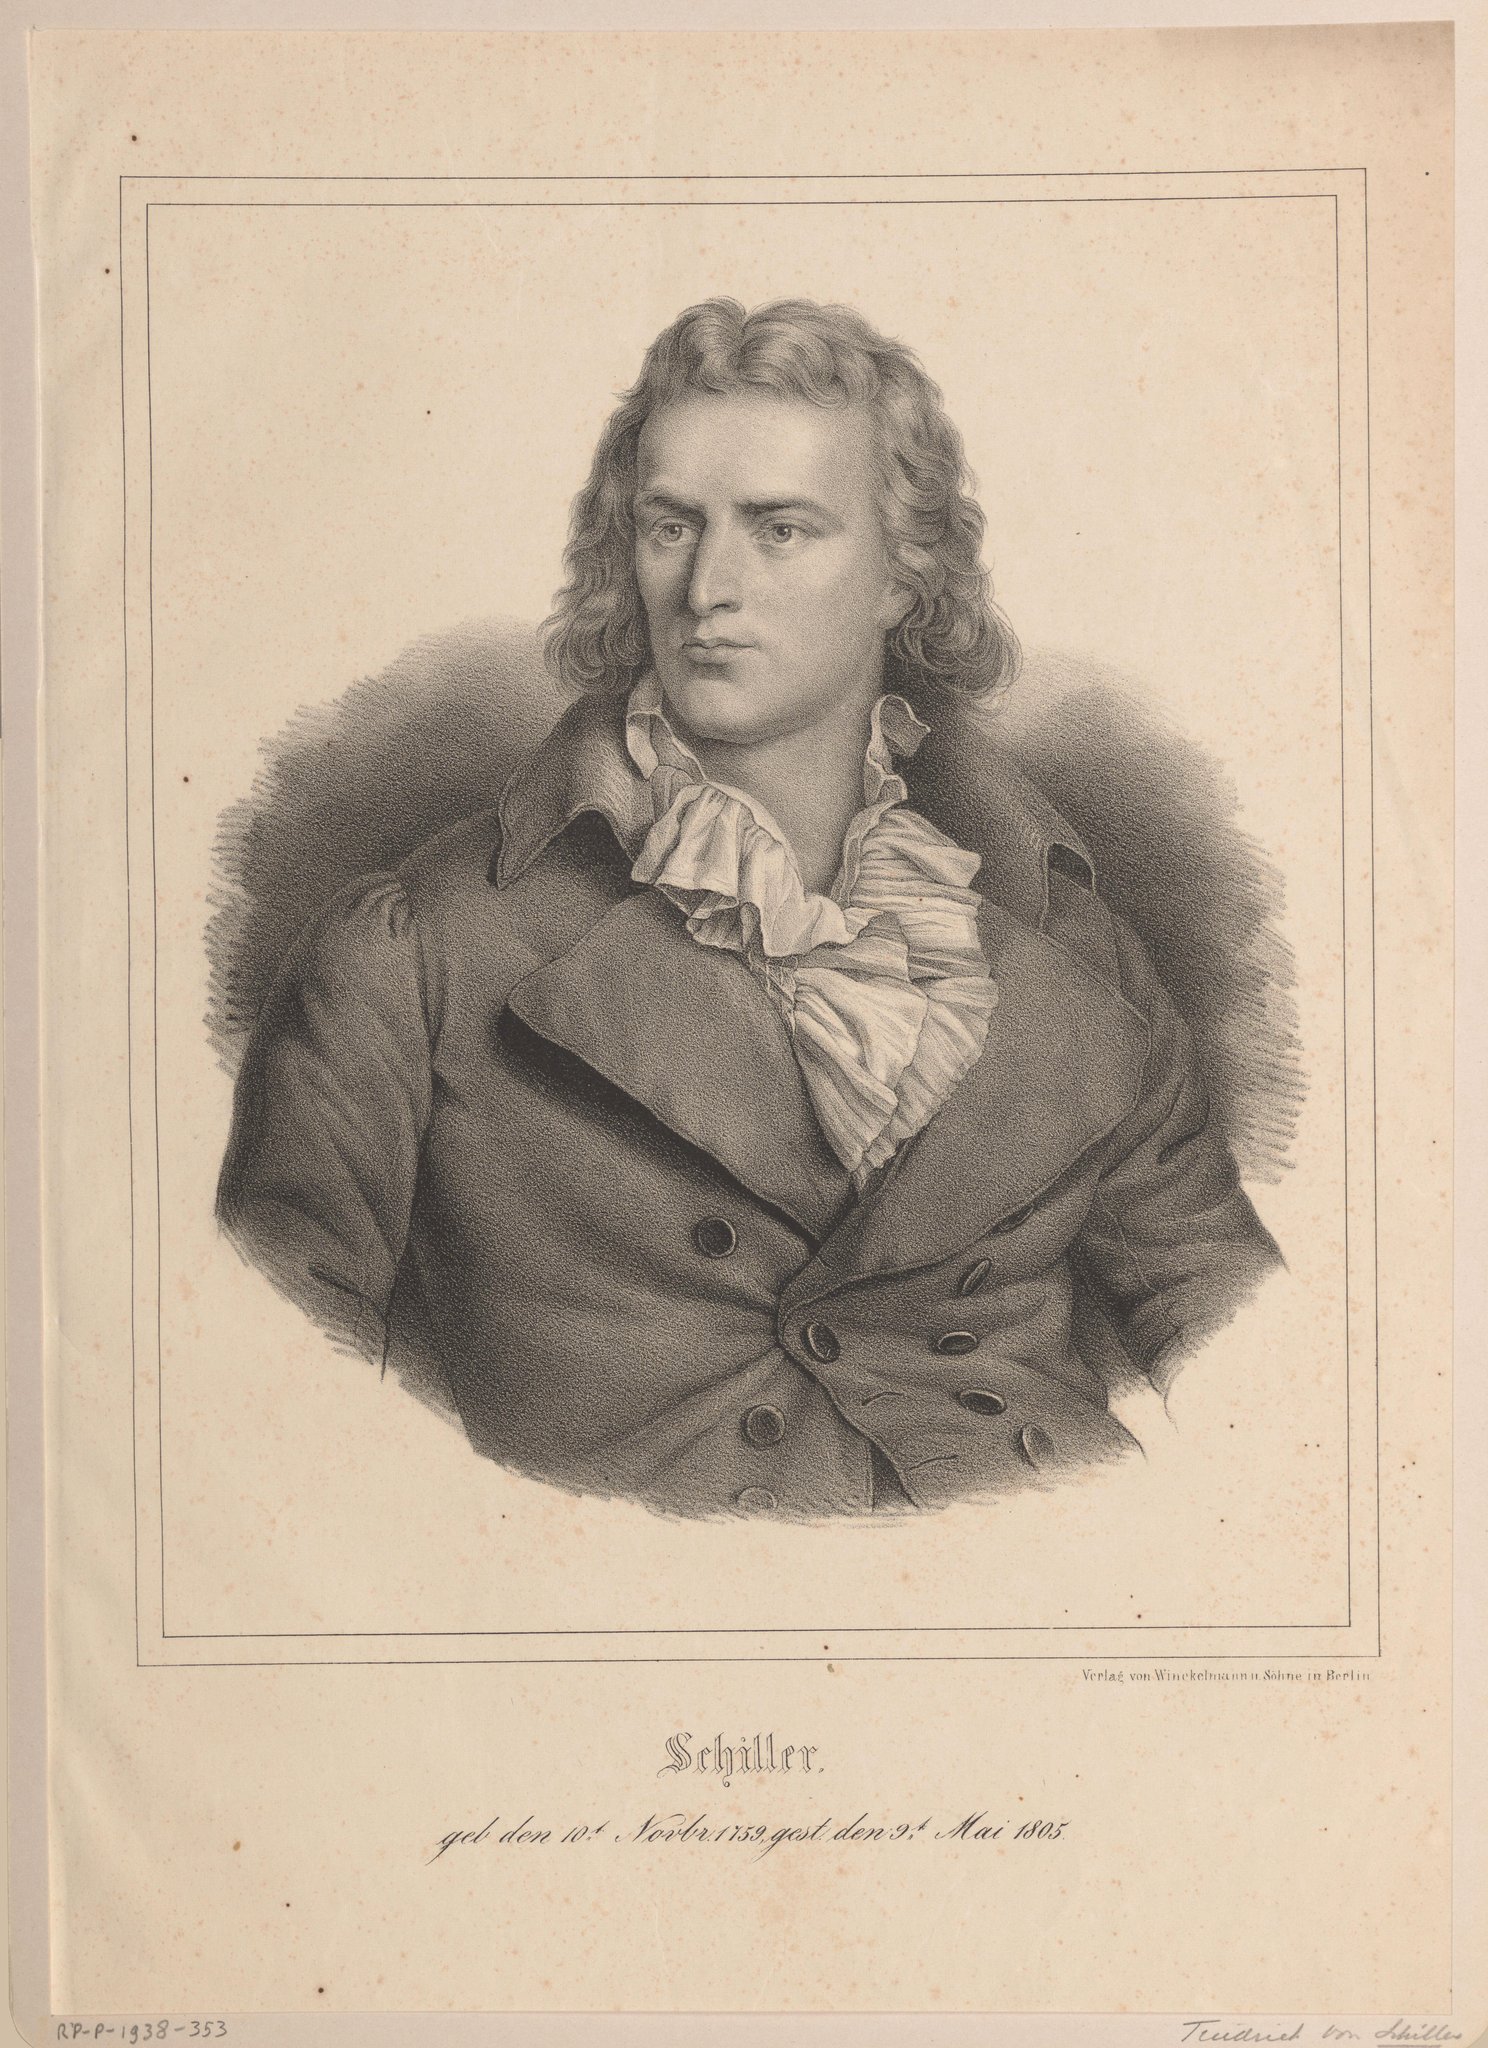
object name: print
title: Portret van Friedrich von Schiller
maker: Anonymous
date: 1830-1849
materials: paper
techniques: lithograph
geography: berlin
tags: friedrich von schiller, scholar, philosopher, historical persons, portrait of a writer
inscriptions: collector's mark: Lugt 2228